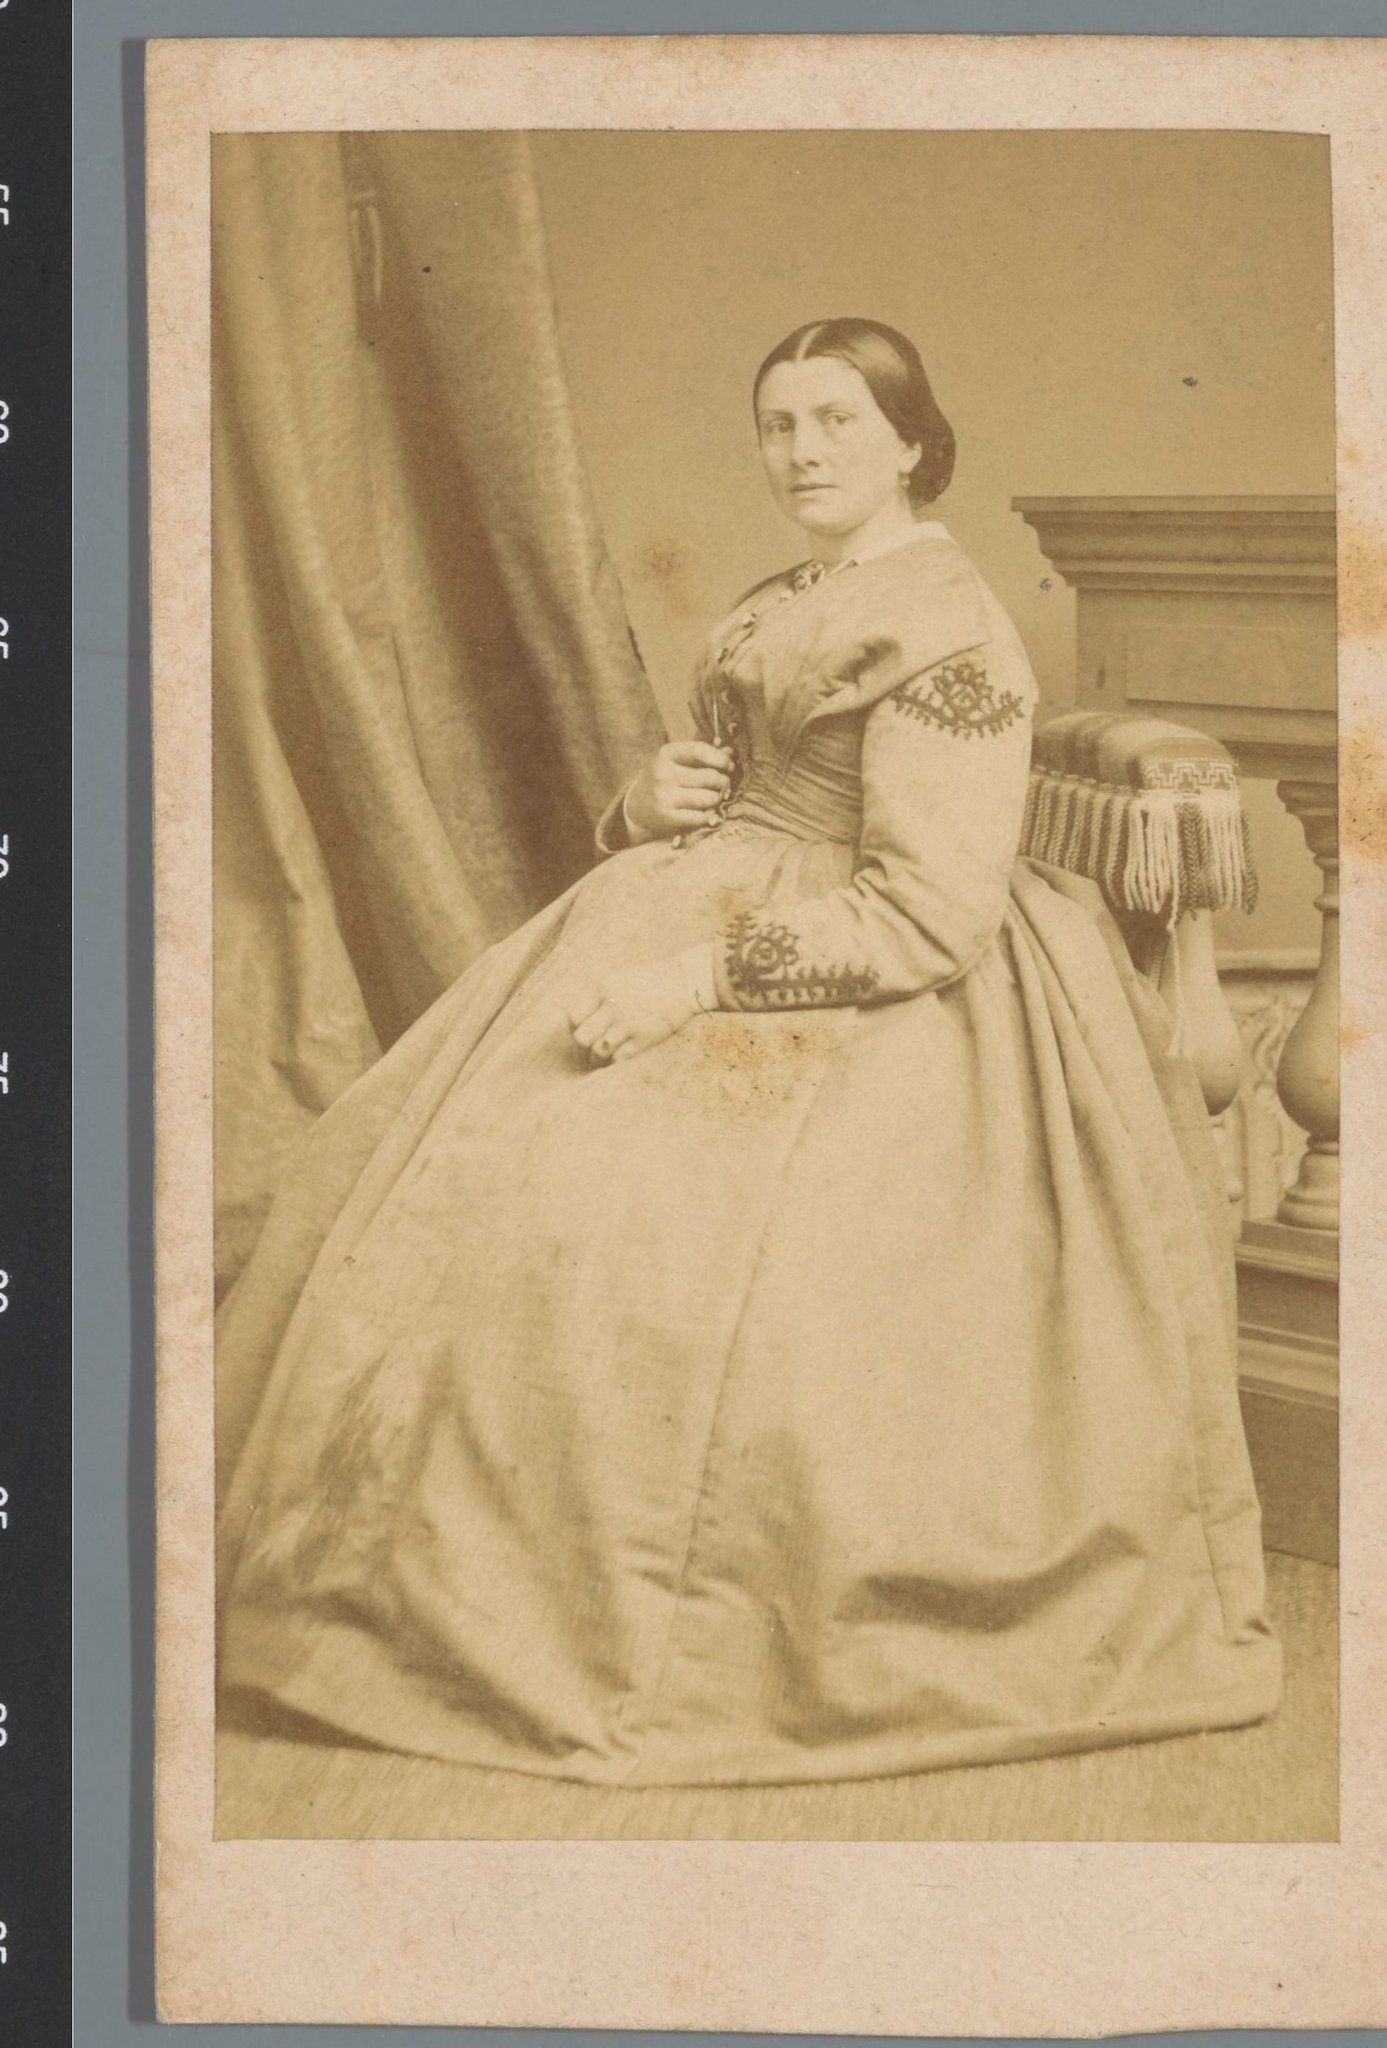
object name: photograph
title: Portret van een onbekende zittende vrouw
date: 1868-1870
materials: cardboard, paper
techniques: albumen print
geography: amsterdam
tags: sitting figure, historical persons - bb - woman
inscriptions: inscription: ‘Photographisch Etablissement/ VAN/ S. van Caspel & Stapert./ Bloemgracht D.D. 43./ AMSTERDAM’